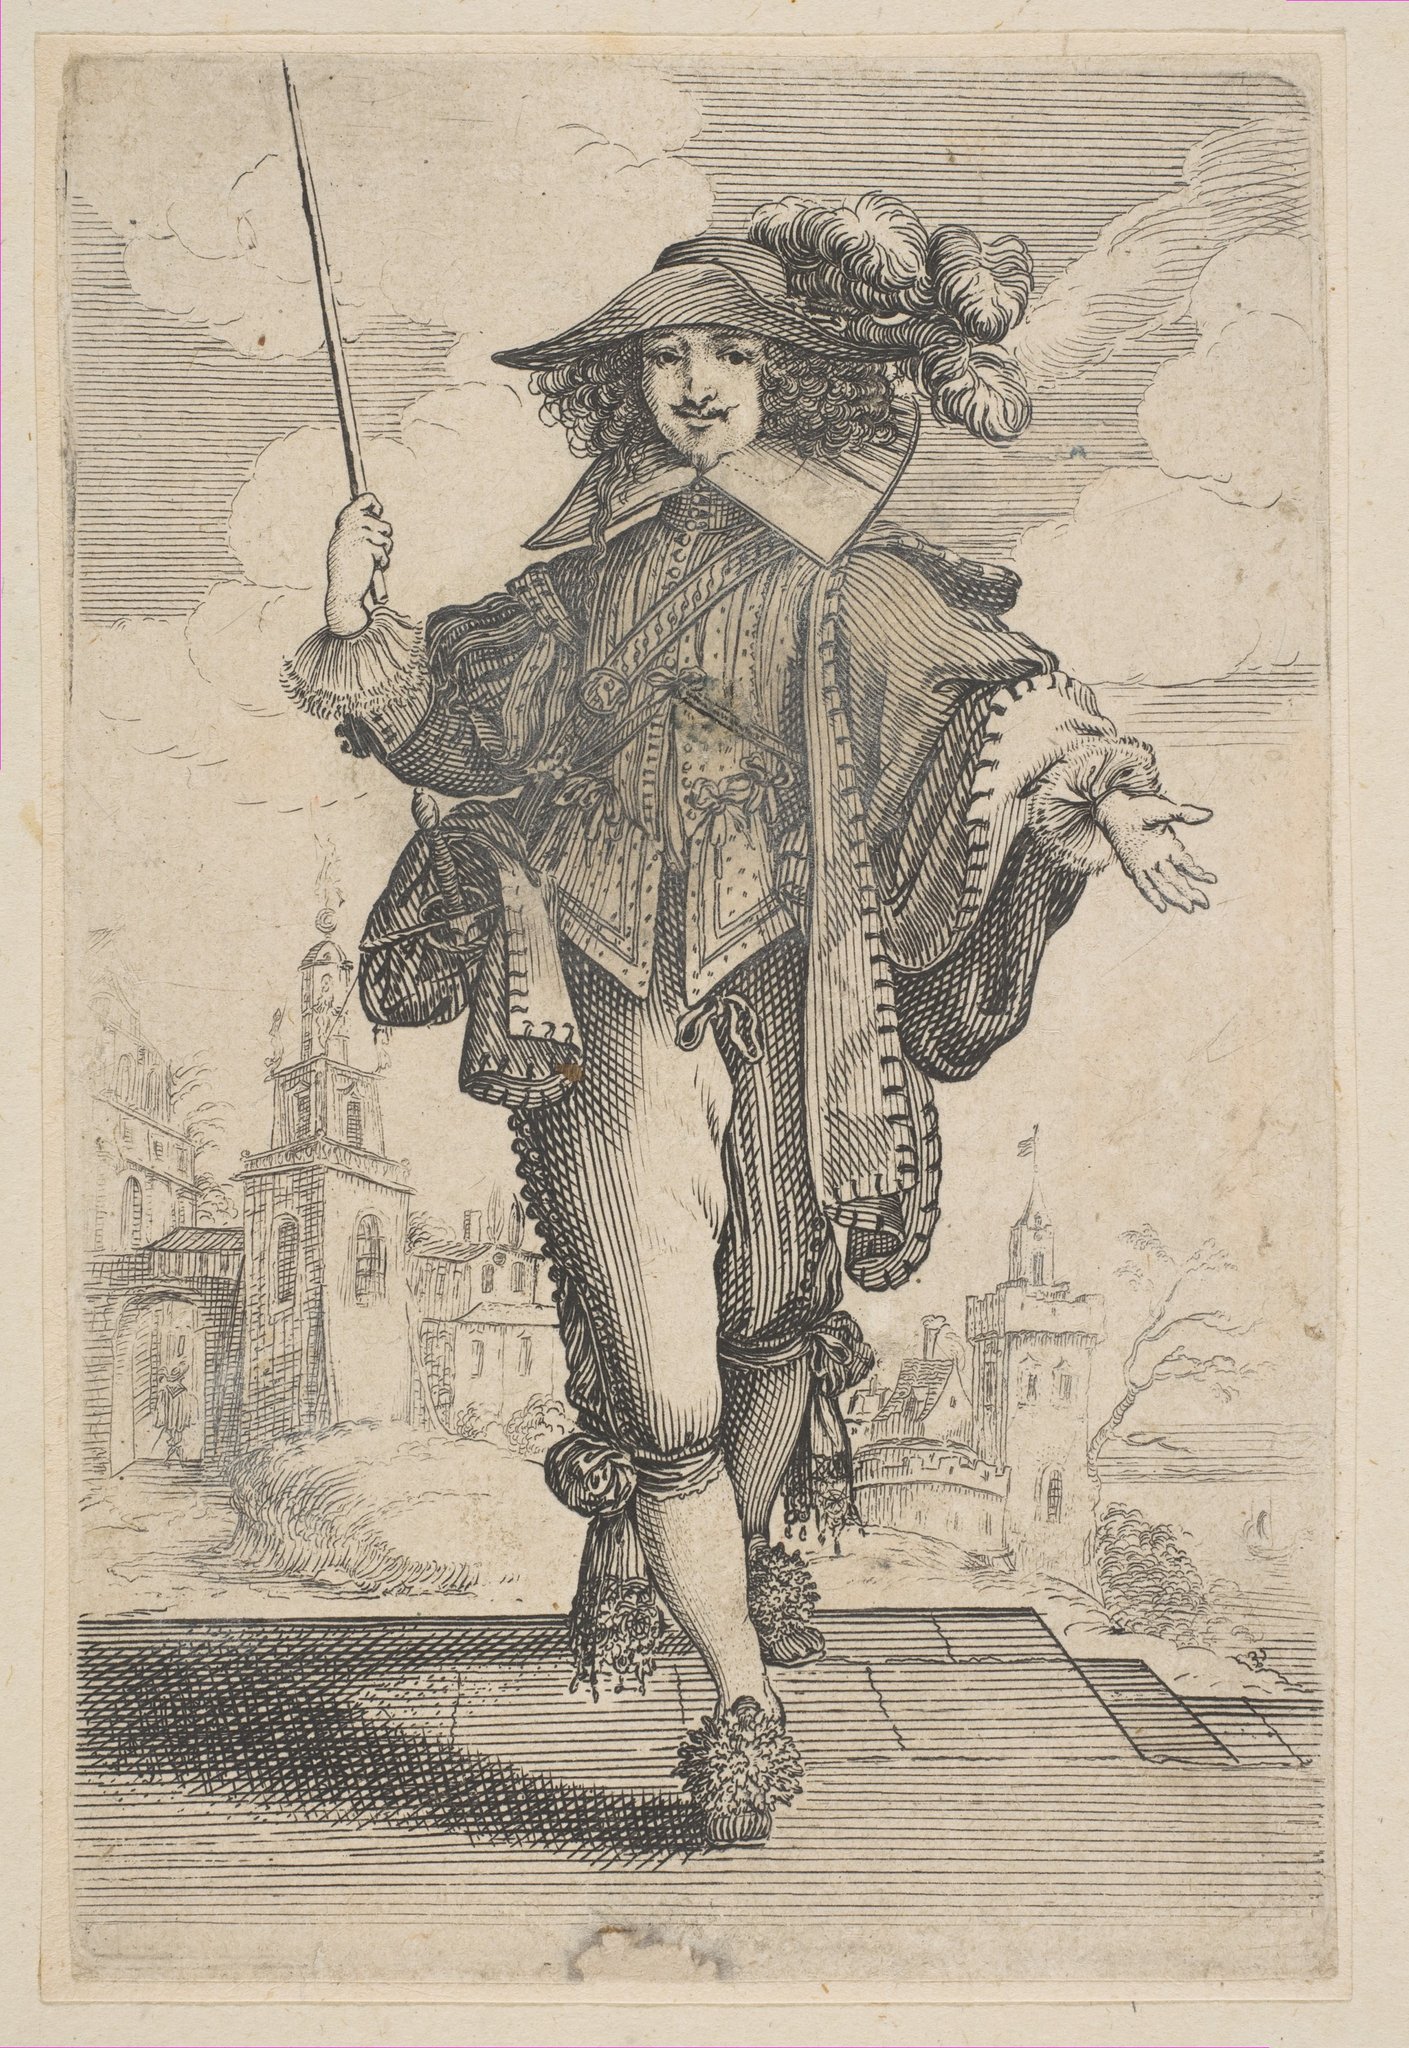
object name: print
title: Gentleman Holding a Crop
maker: anonymous, french, 17th century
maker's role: artist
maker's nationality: french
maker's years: 1600-1700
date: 1629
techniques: etching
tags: men